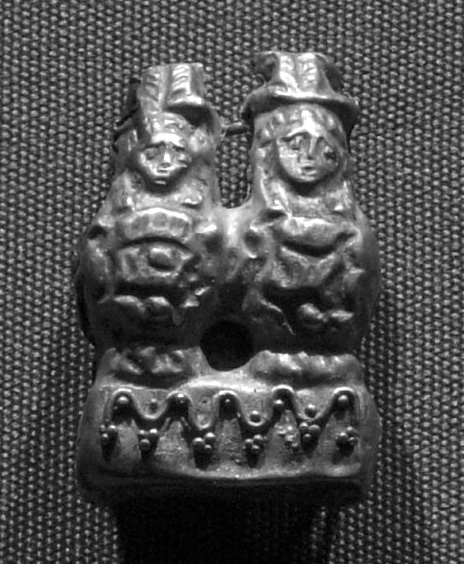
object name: pendant, osiris, isi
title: Pendant: Osiris and Isis of Canopus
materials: gold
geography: egypt